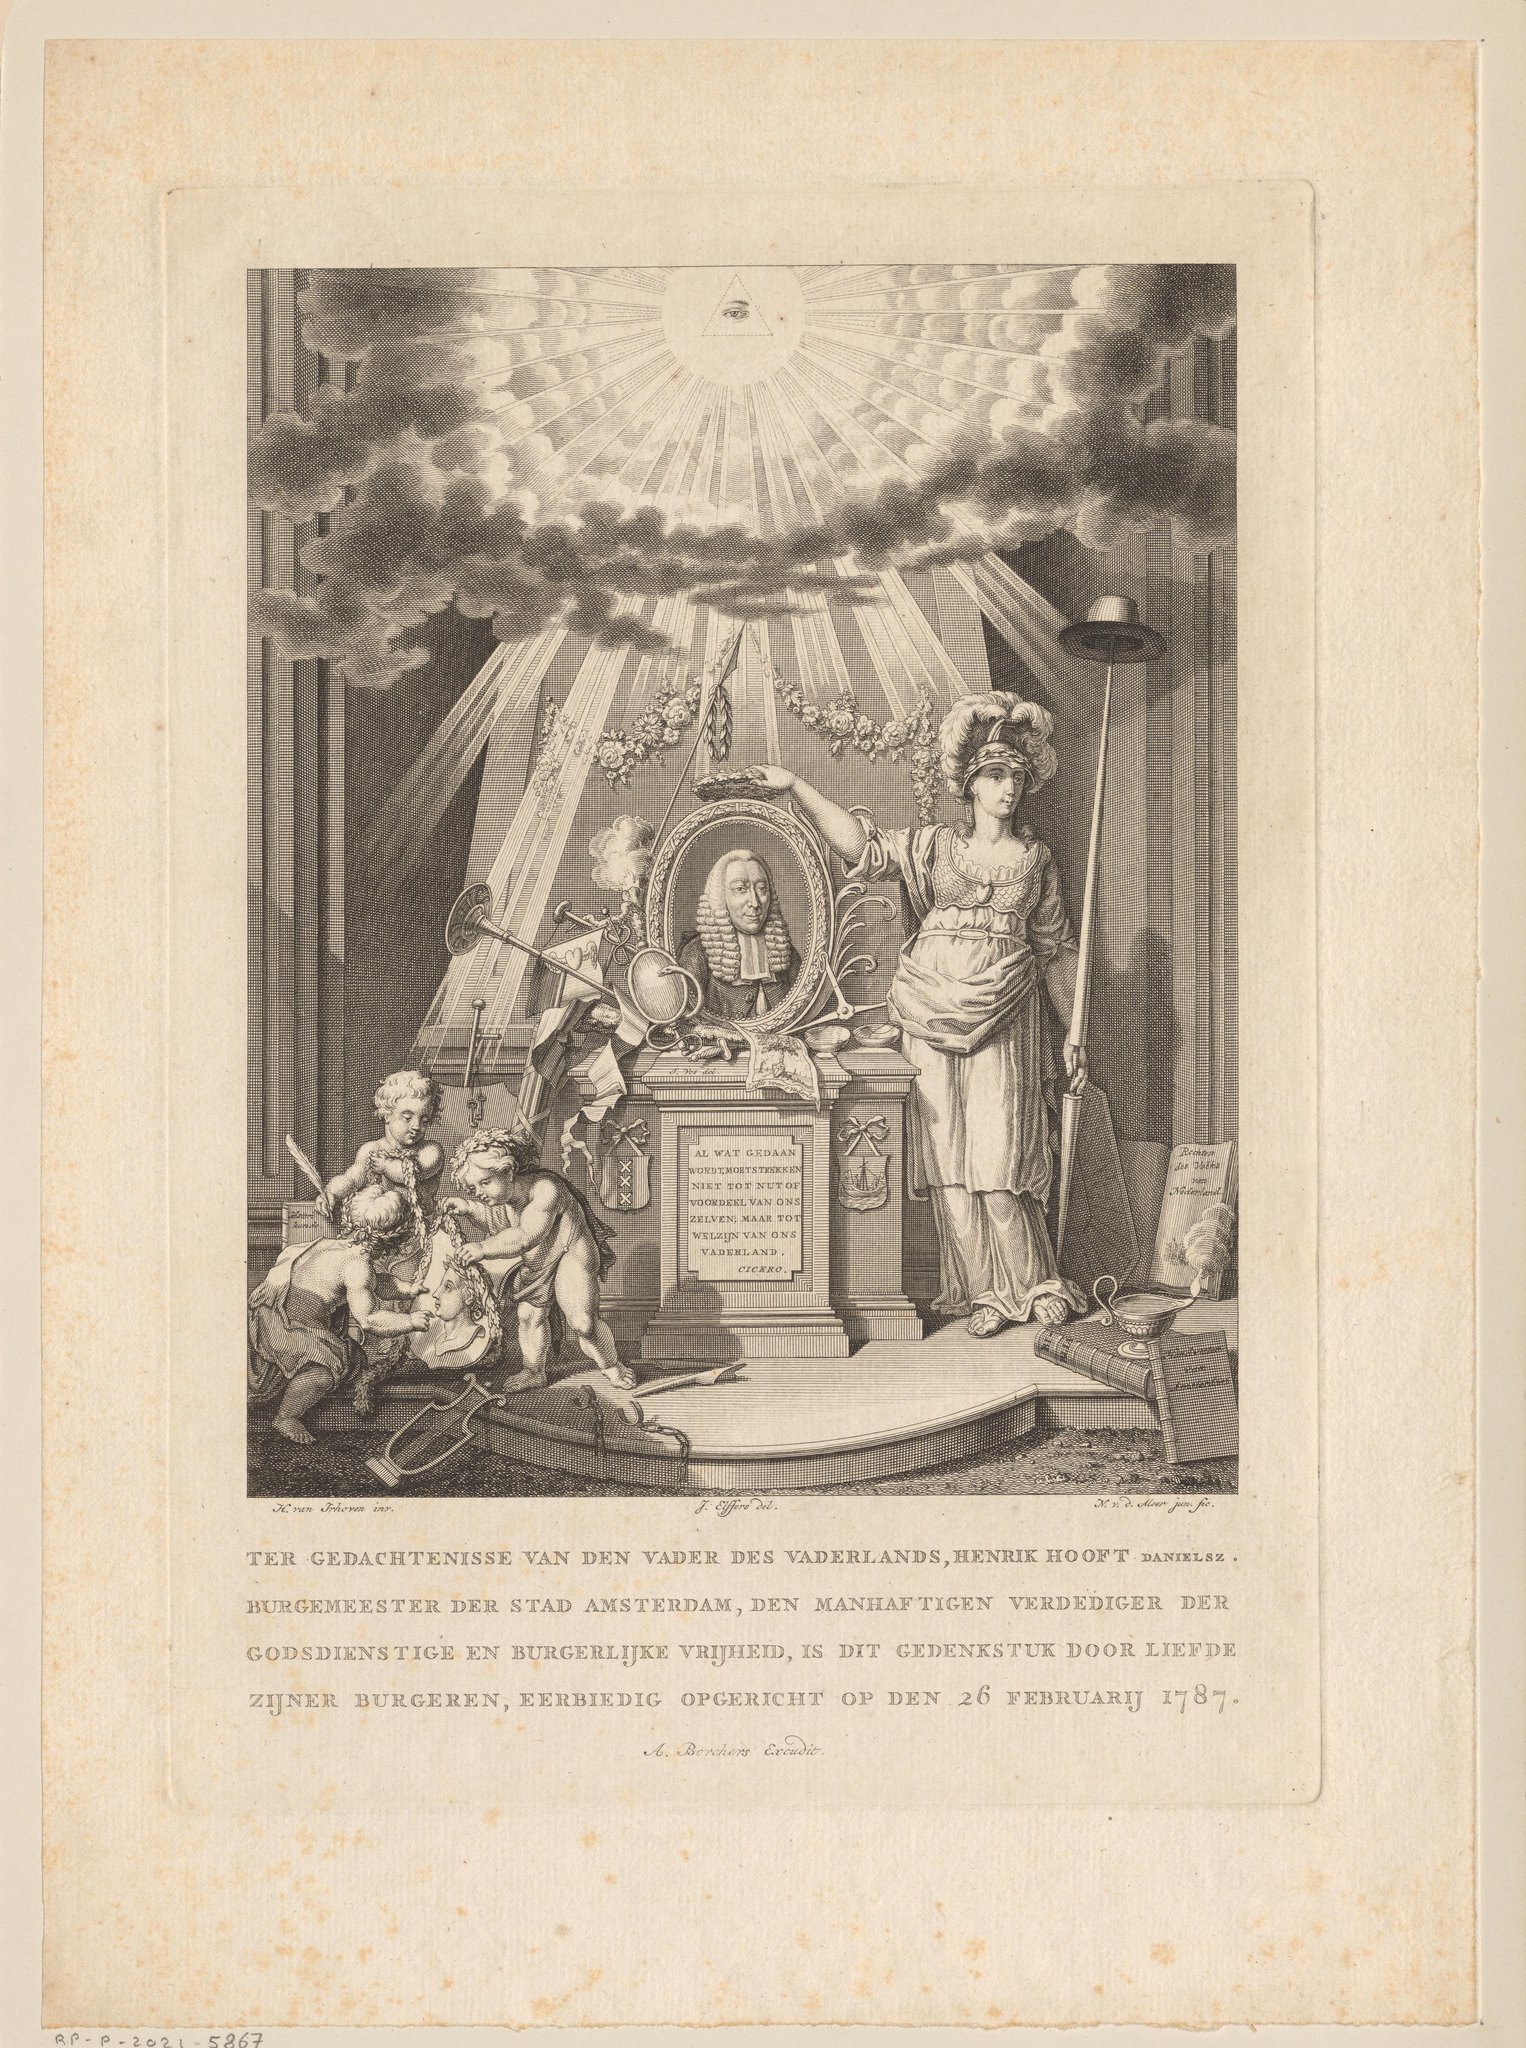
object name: print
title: Gedenkteken voor Hendrik Danielsz. Hooft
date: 1787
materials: paper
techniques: engraving, etching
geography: amsterdam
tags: marcus tullius cicero, mayor, hendrik danielsz. hooft, mayor, burgomaster, historical persons, the all-seeing eye, triangle with eye ~ symbol of god the father, freedom, liberty; 'libertà' (ripa), cupids: 'amores', 'amoretti', 'putti', armorial bearing, heraldry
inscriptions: date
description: Gedenkteken voor Hendrik Danielsz. Hooft, burgemeester van Amsterdam. Op het monument staat zijn portret, dat gelauwerd wordt door Vrijheid. Zij houdt een lans met de vrijheidshoed in haar andere hand. Links spelen drie putti met het portret van Cicero. Midden boven het alziend oog van God. Onderaan in de marge een tekst in het Nederlands.